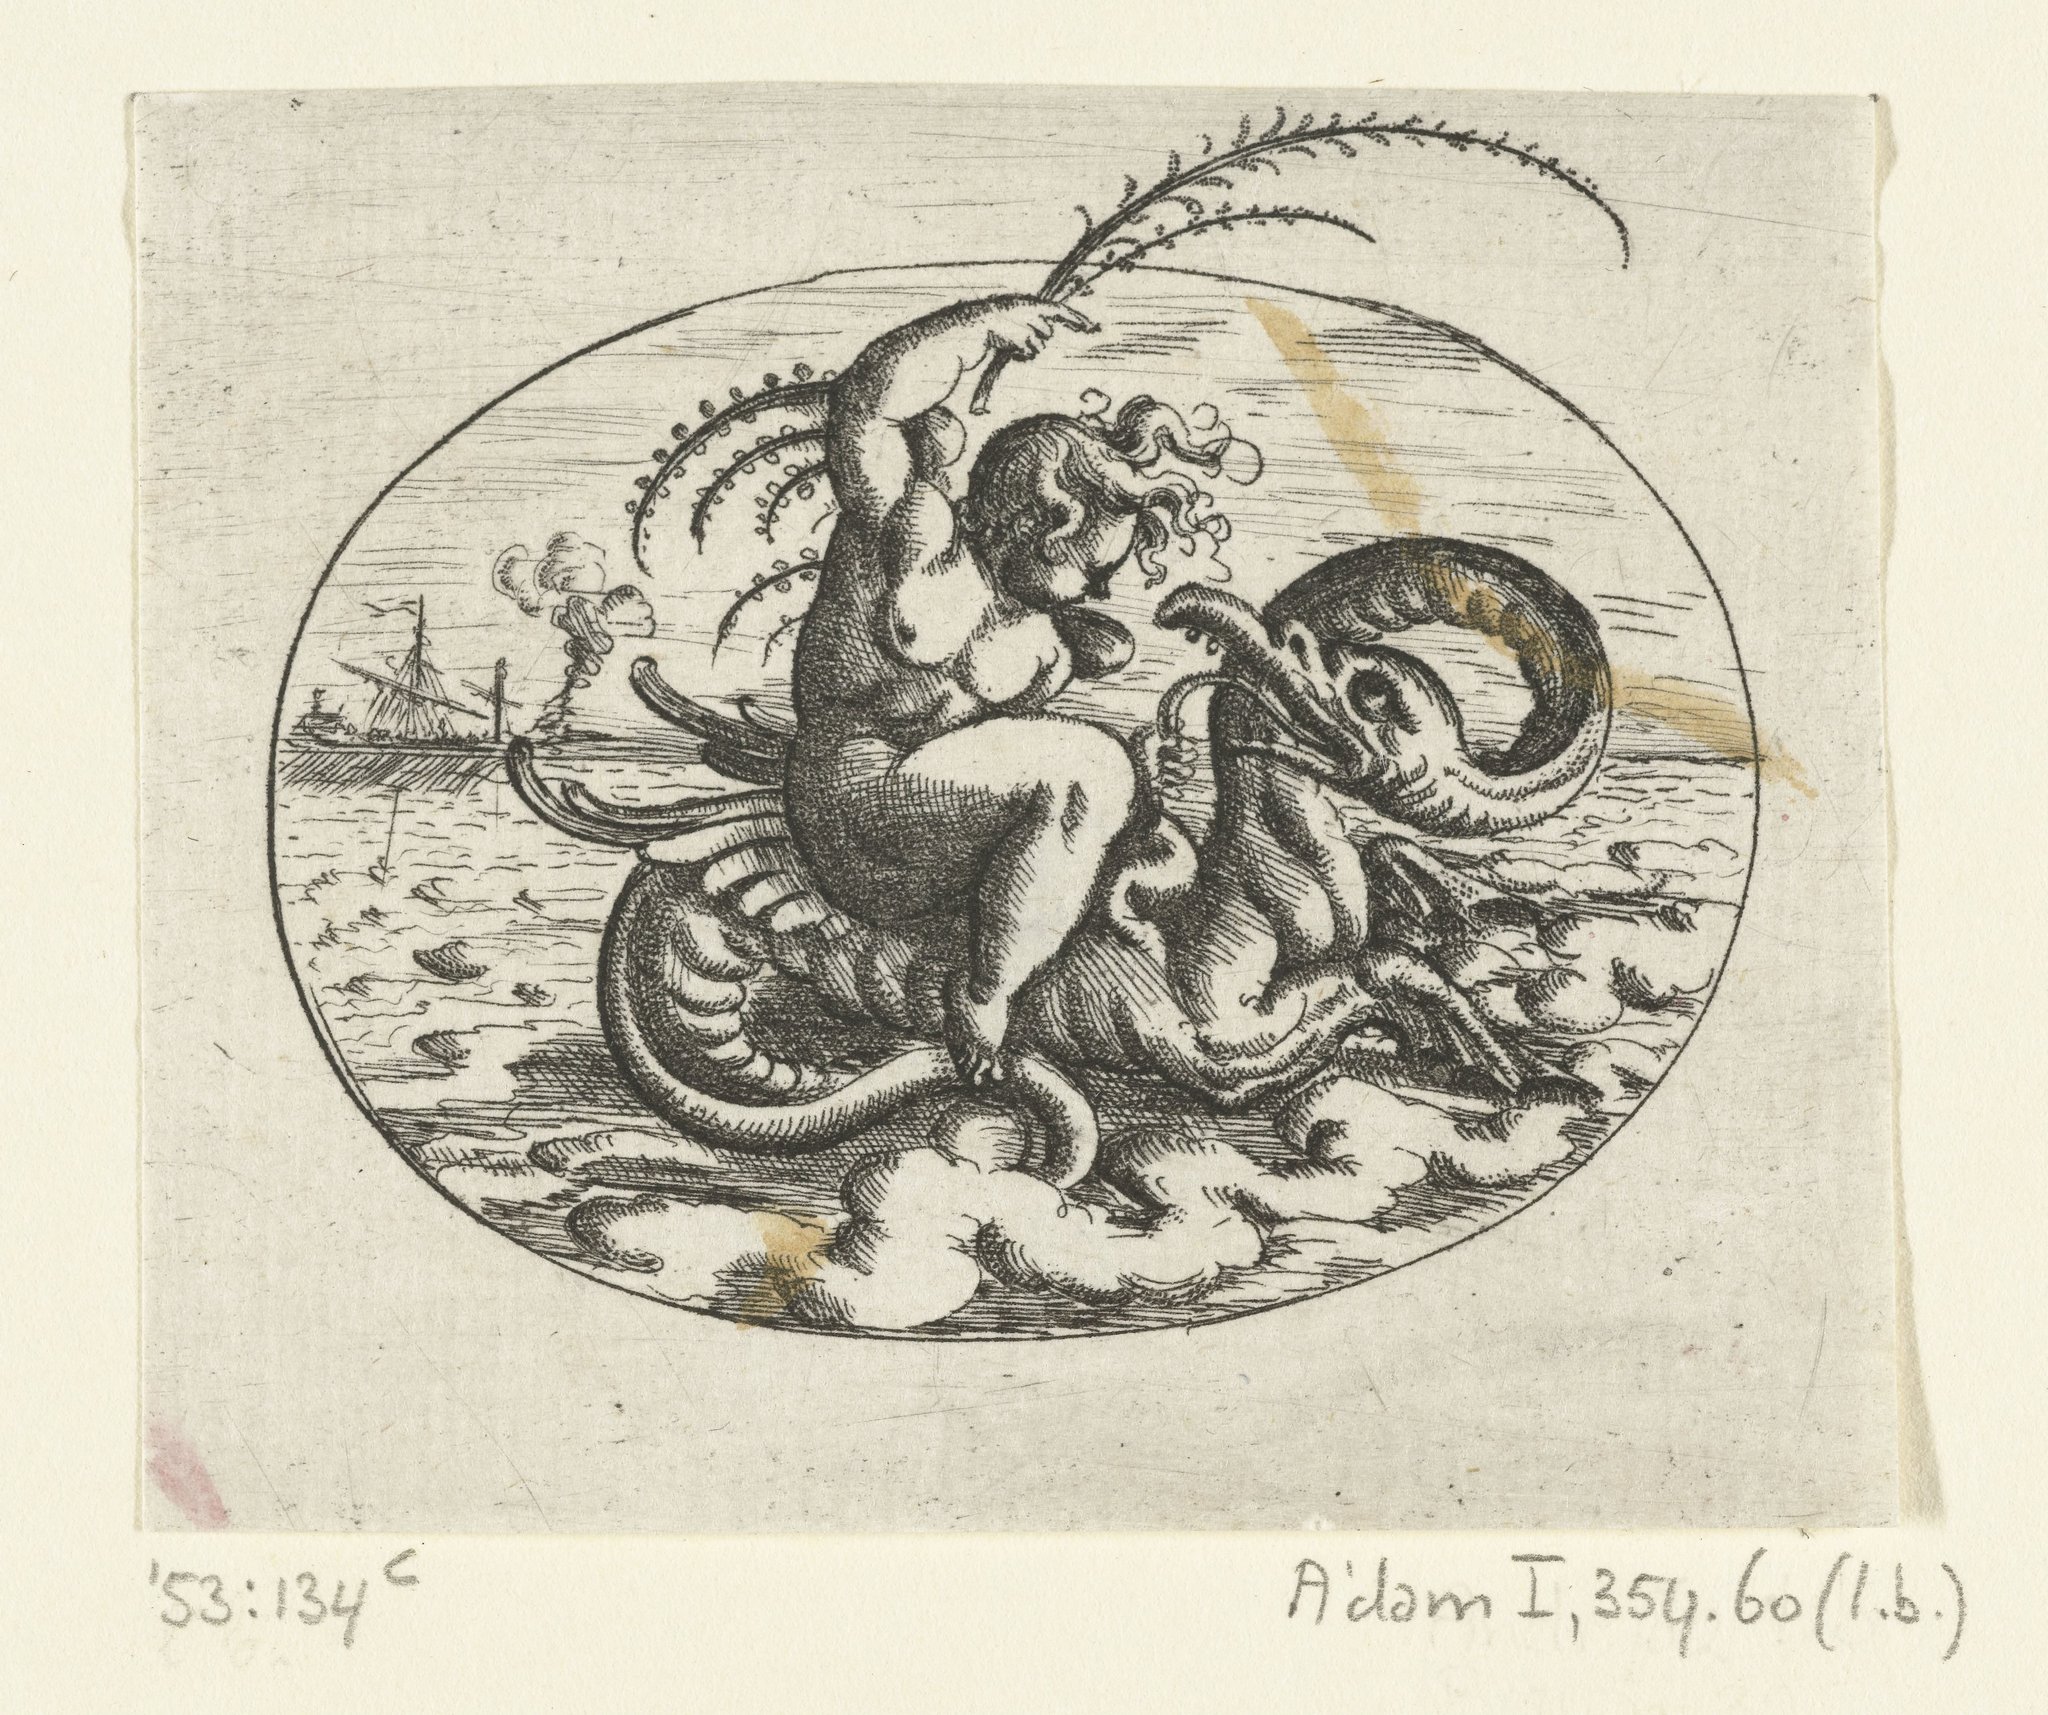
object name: print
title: Das Neuw Grottesken Buch Nürnberg 1610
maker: christoph jamnitzer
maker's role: draughtsman, goldsmith, print maker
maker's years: 1563-1618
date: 1573-1610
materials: paper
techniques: etching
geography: germany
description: Een putto met een tak in de hand op een zeedraak. Blad uit een serie vlakdecoraties met grotesken, cartouches, ovalen, mascarons, putti en fantastische wezens. De serie bestaat uit drie titelbladen, twee tekstbladen met de opdracht en het voorwoord en 60 bladen, verdeeld over drie boeken.